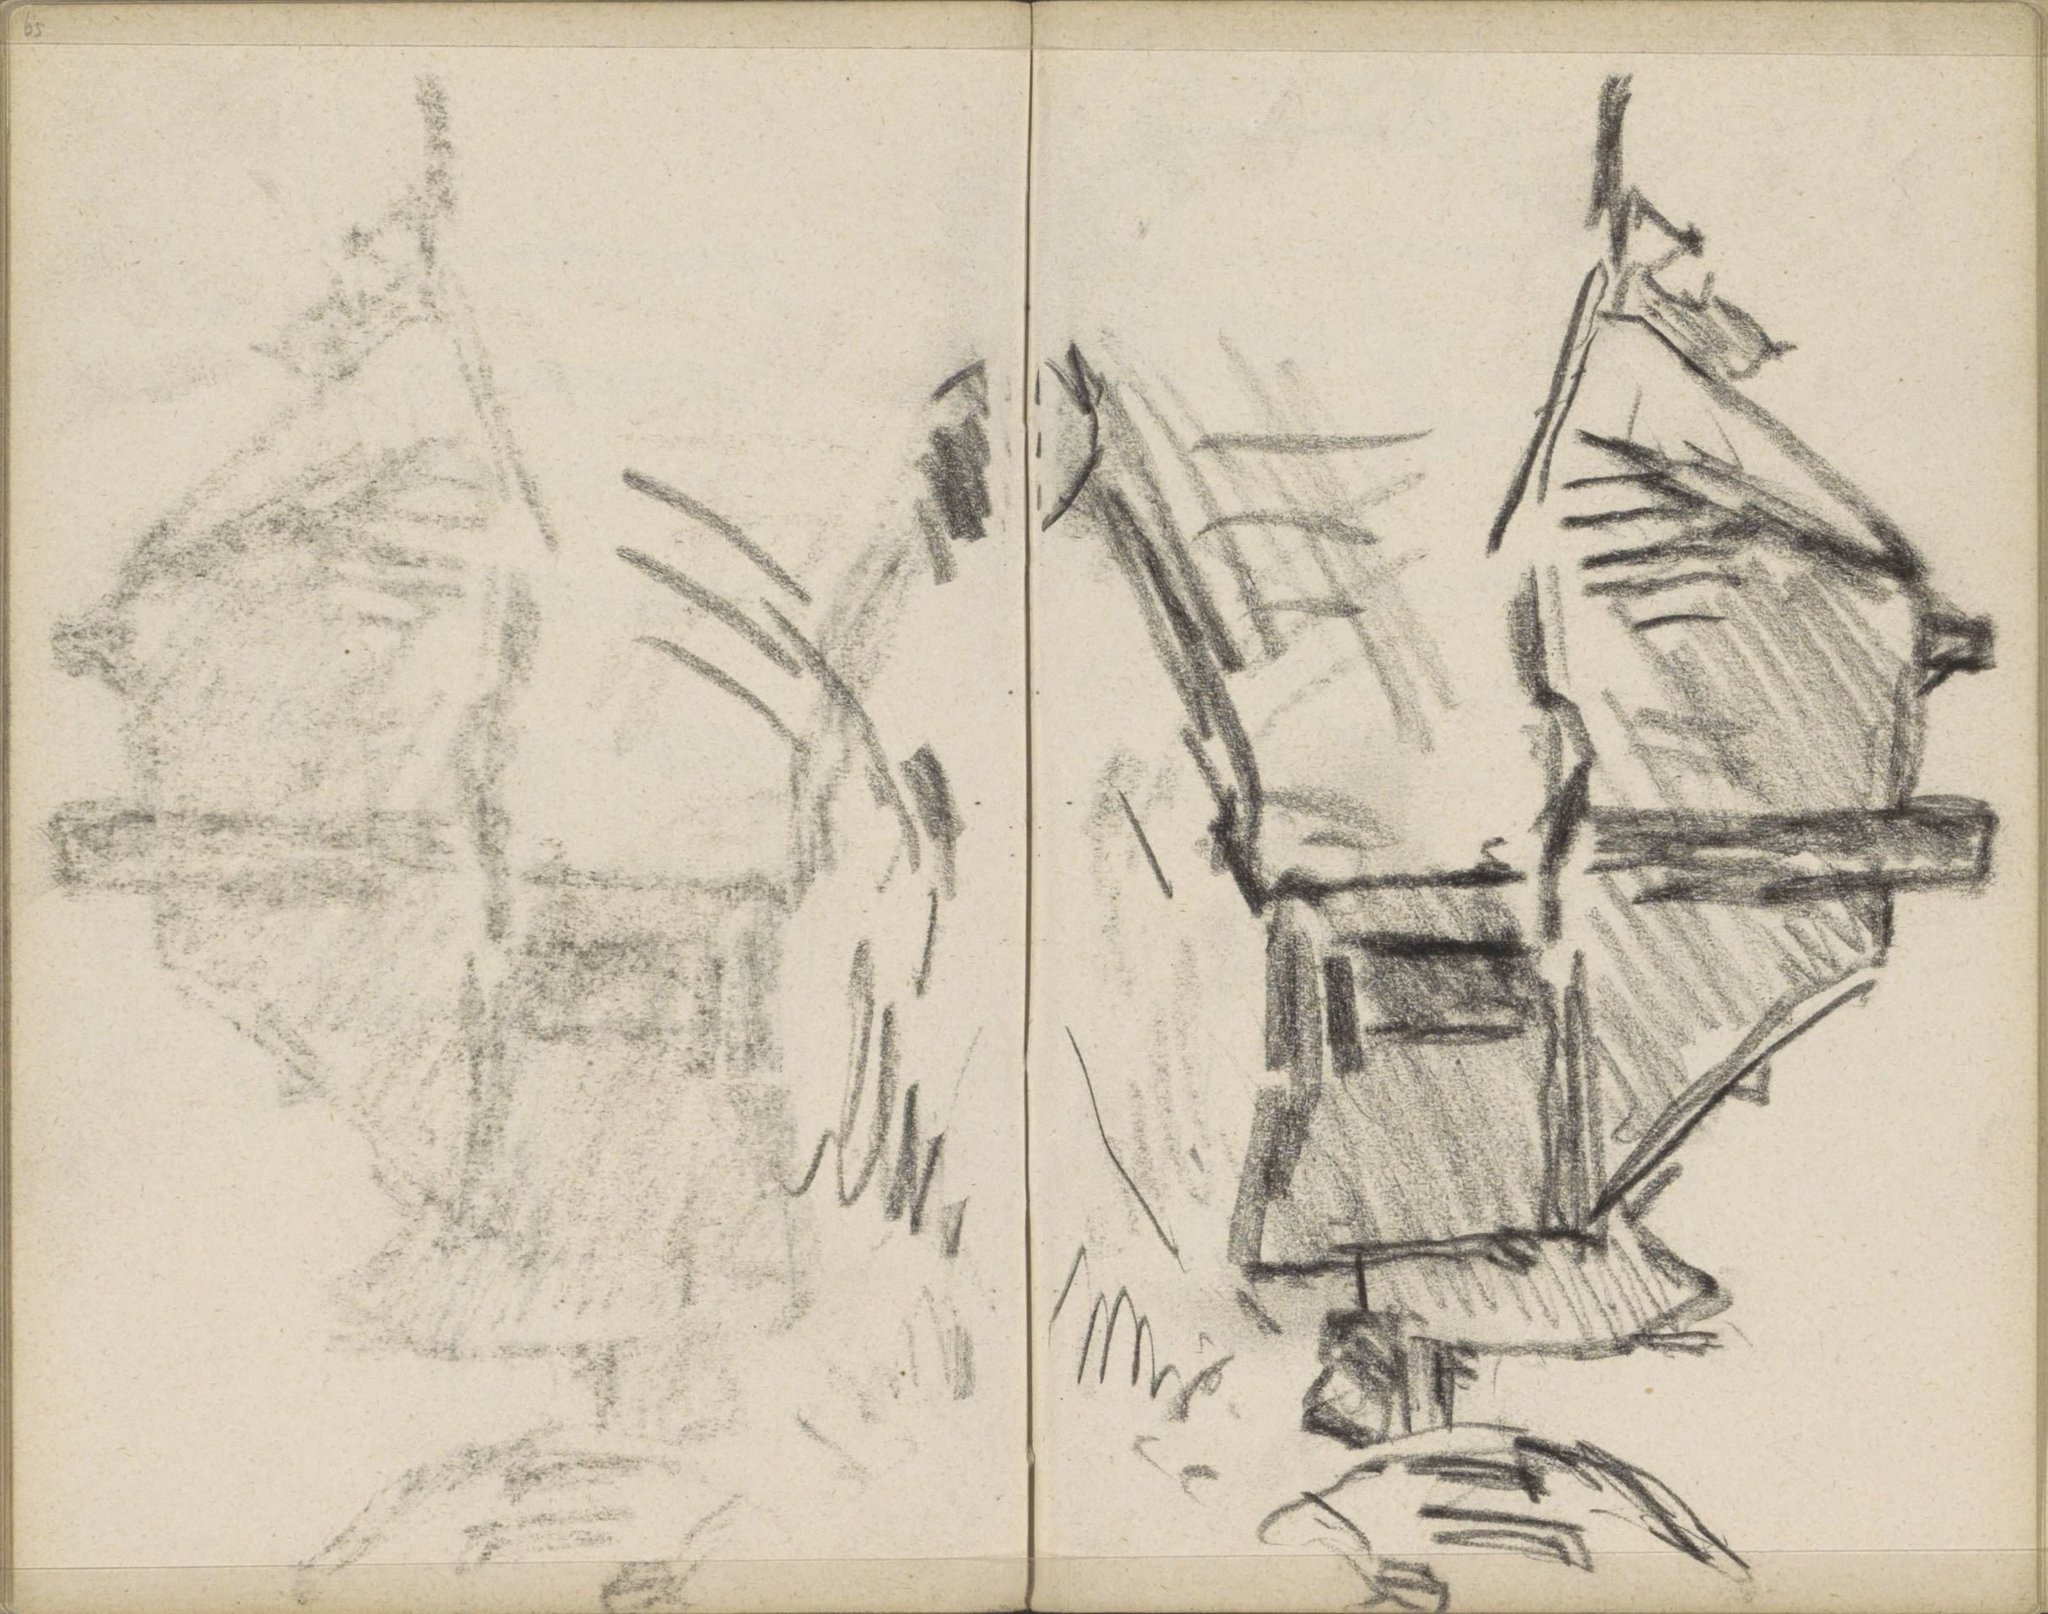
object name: sketchbook leaf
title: Gezicht op huizen, mogelijk in de Marnixstraat te Amsterdam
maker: george hendrik breitner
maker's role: draughtsman, painter, print maker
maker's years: 1857-1923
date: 1907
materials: chalk, paper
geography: amsterdam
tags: urban housing, street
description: Gezicht op huizen, mogelijk in de Marnixstraat te Amsterdam. Pagina 65 en pagina 66 uit een schetsboek met 46 bladen vervaardigd in Amsterdam, Rotterdam en Haarlem.